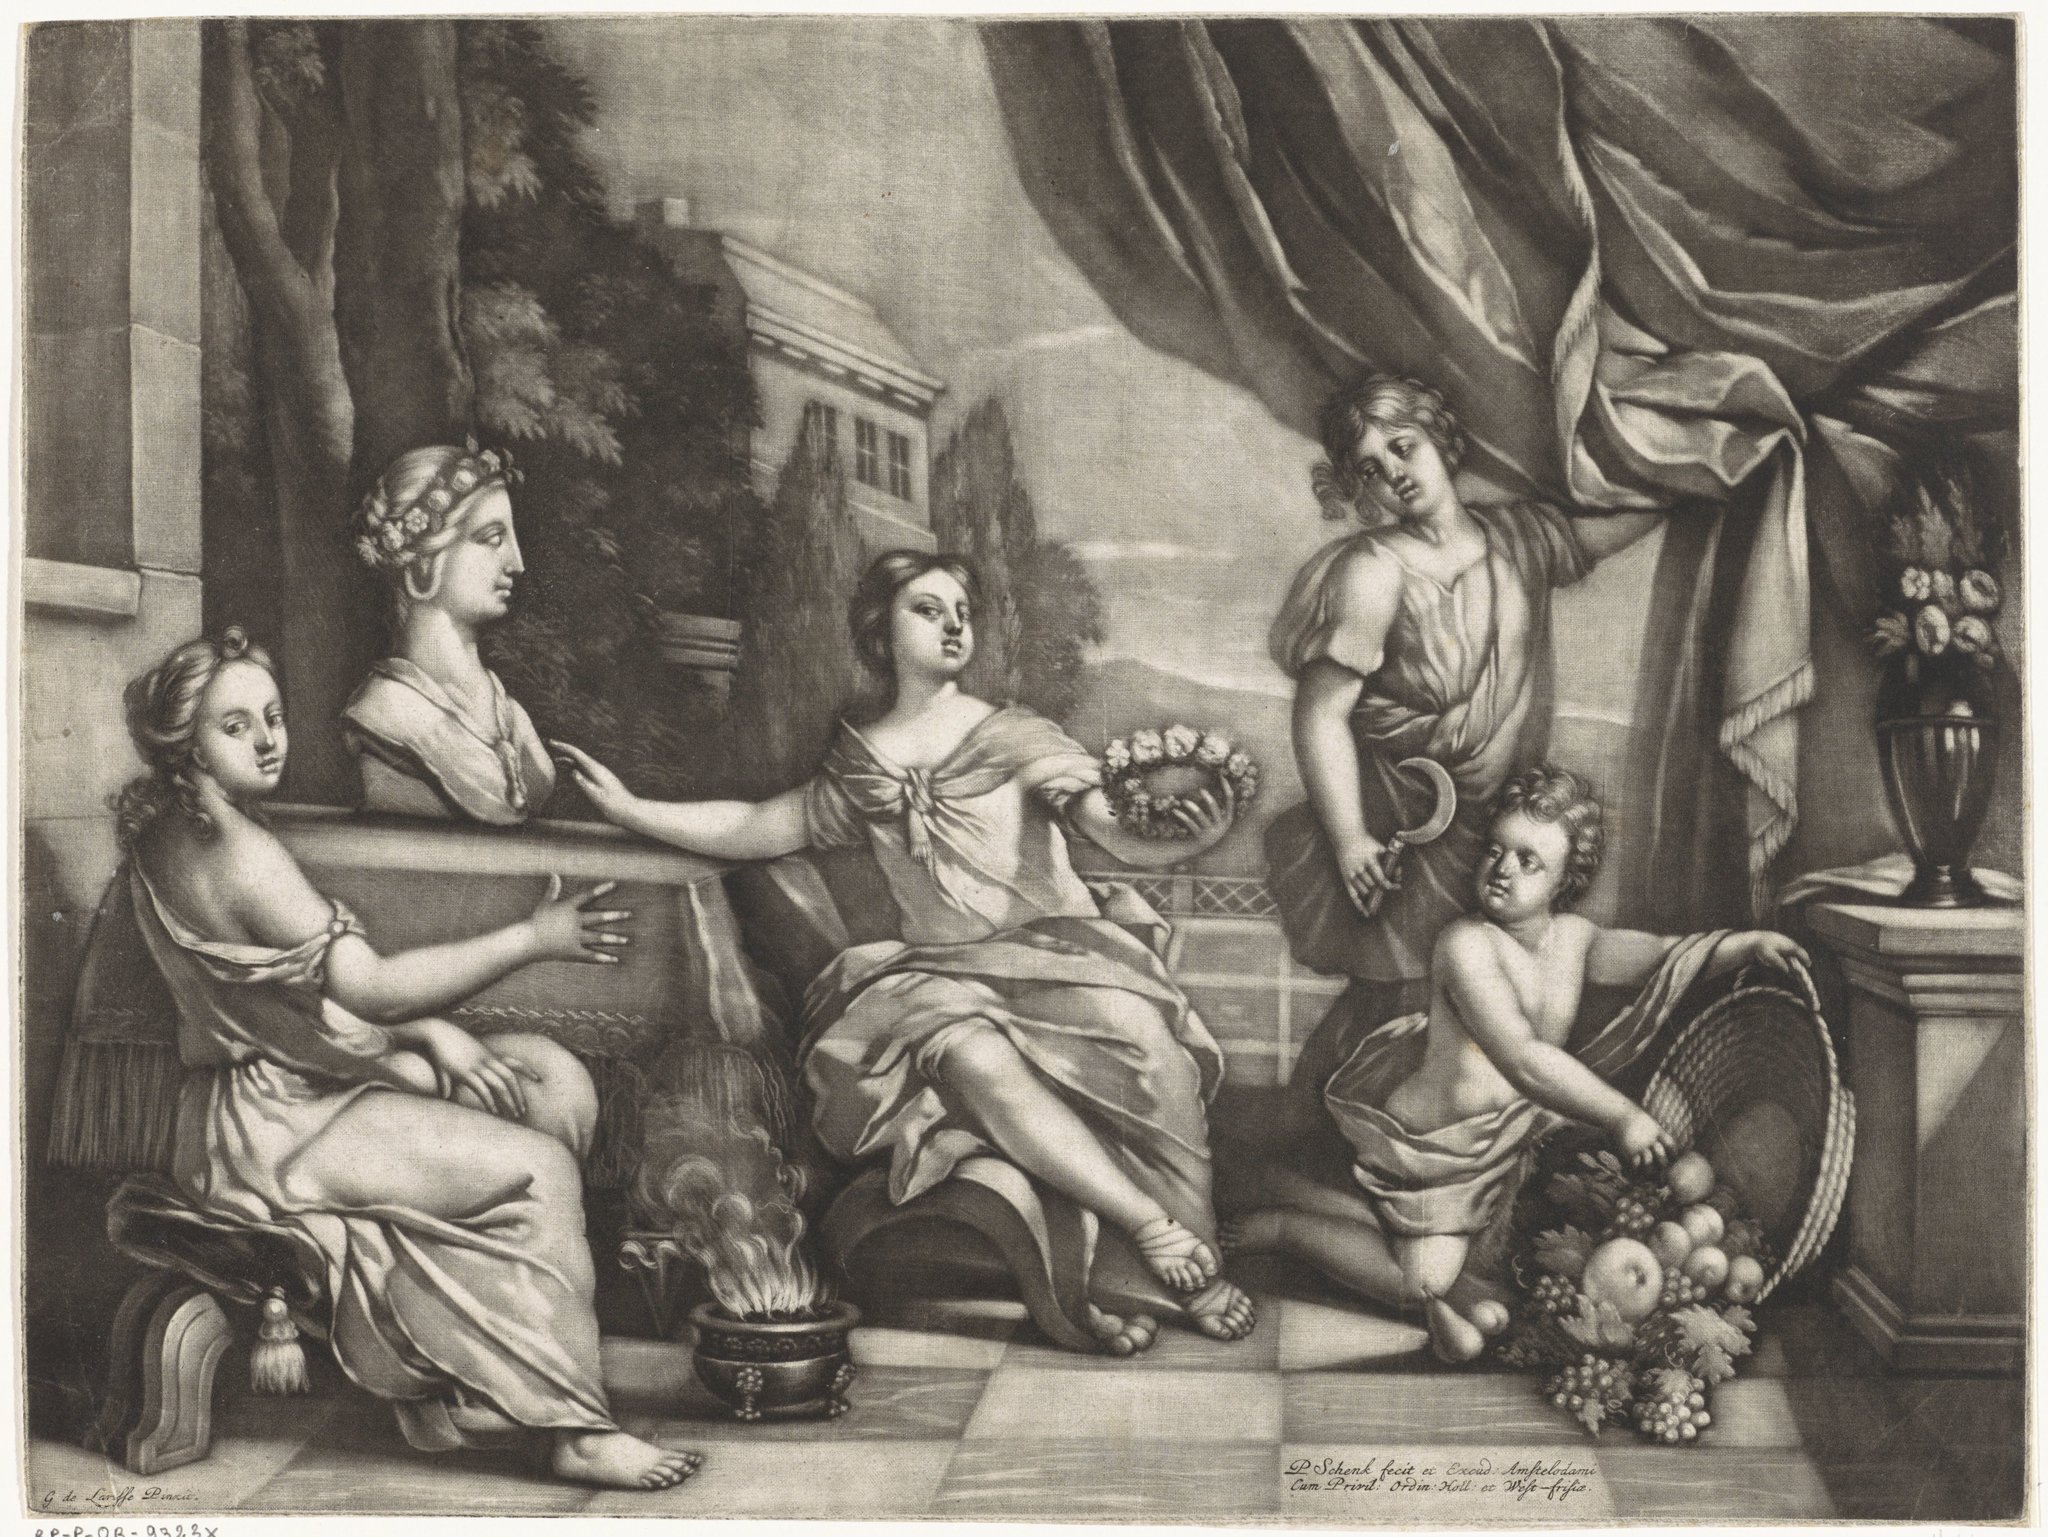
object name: print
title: Personificaties van de vier seizoenen op een terras bij een buste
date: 1670-1713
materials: paper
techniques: engraving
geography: amsterdam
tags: seasons of the year represented by scenes showing human activities, usually in a landscape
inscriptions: collector's mark: Lugt 2228